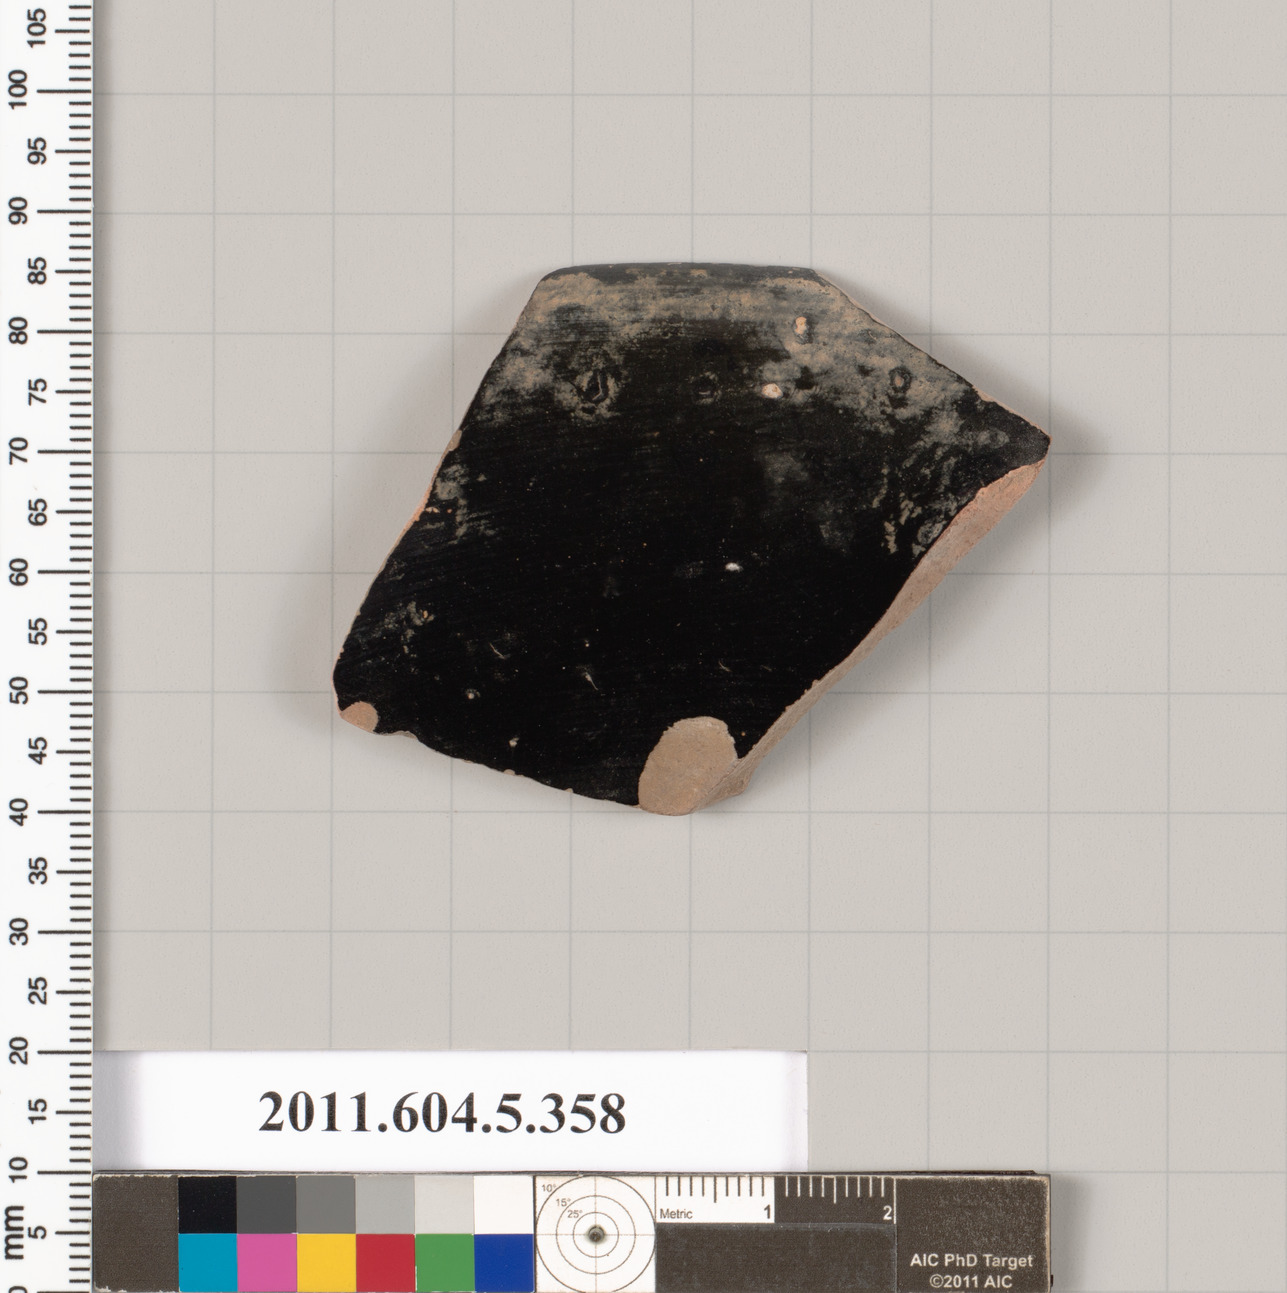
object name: kylix fragment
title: Terracotta rim fragment of a kylix (drinking cup)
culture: greek, attic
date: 600-401 BCE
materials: terracotta